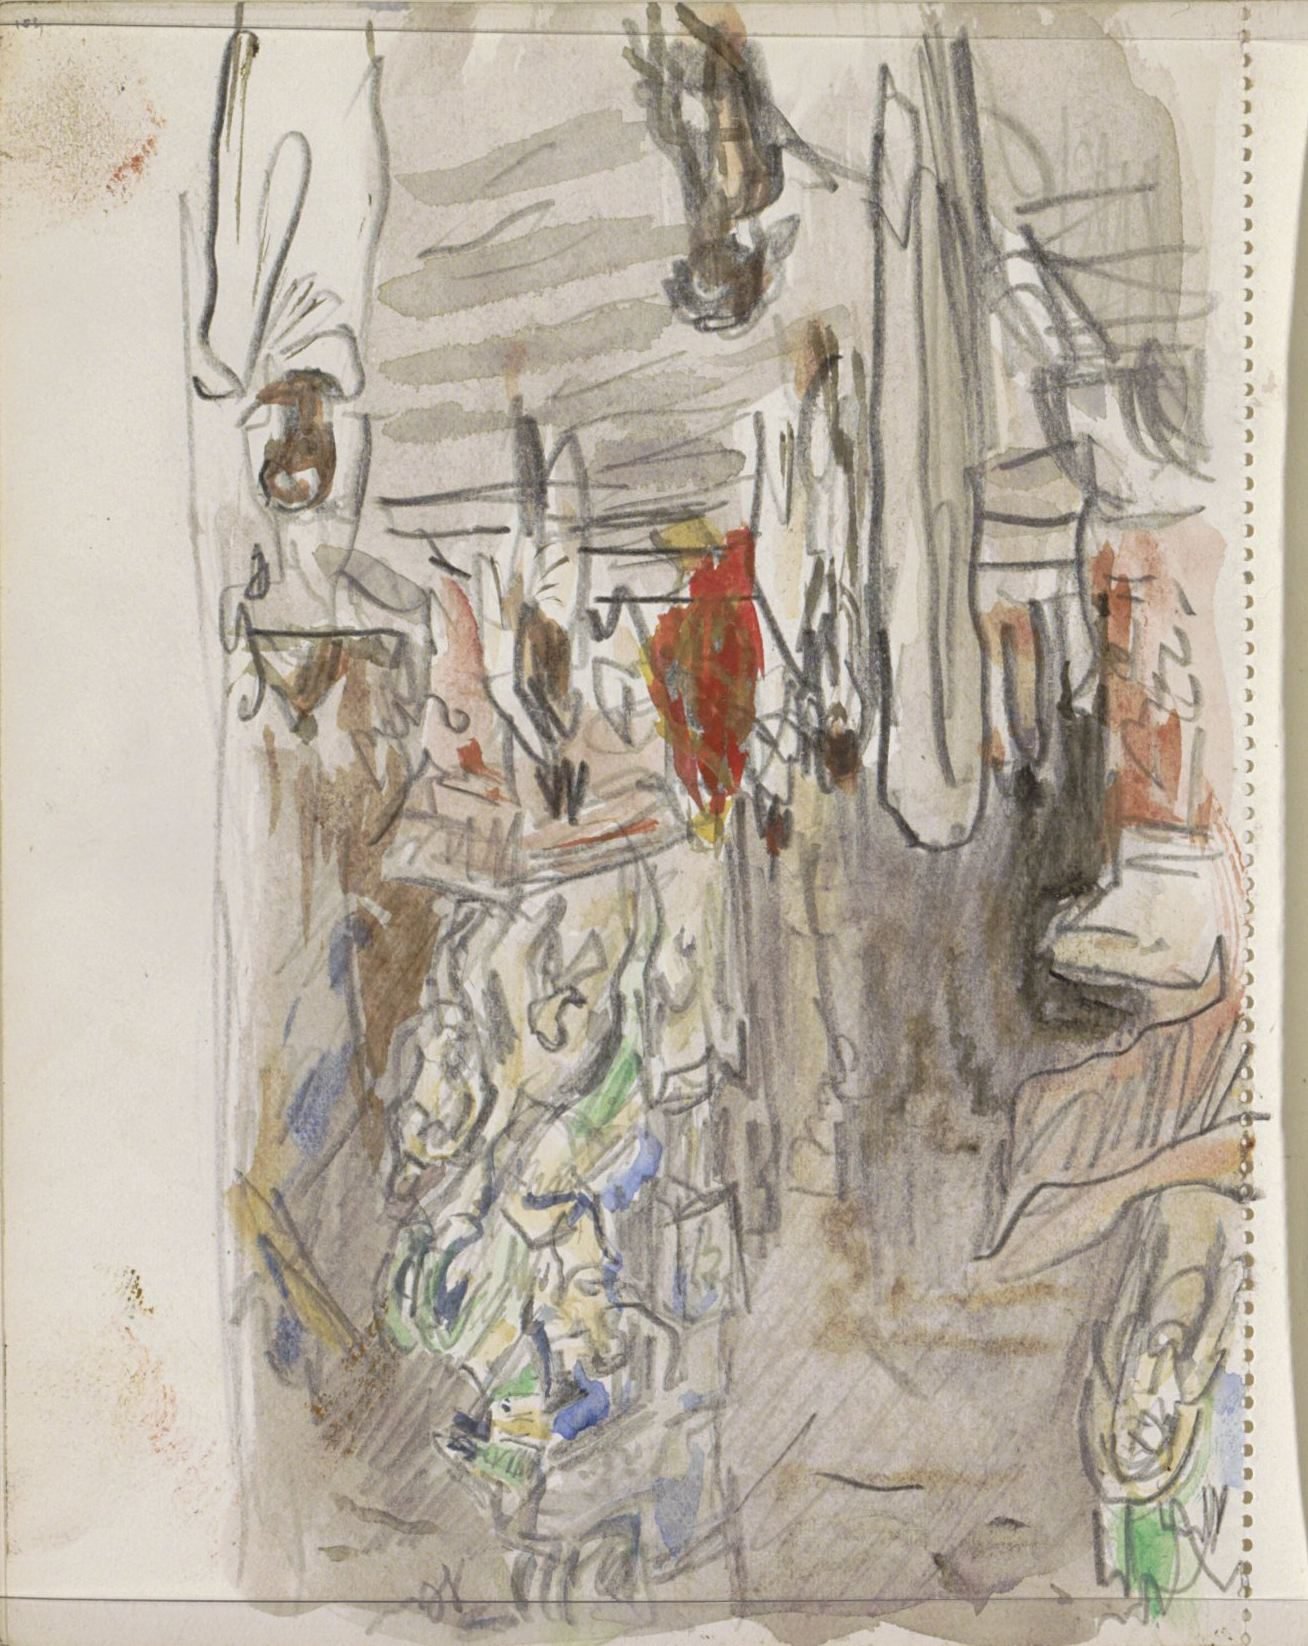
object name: sketchbook leaf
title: Indiërs op een tempeltrap, mogelijk de Meenakshi Amman Tempel in Madurai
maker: marius bauer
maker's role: draughtsman, print maker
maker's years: 1867-1932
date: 1924-1925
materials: paper, pencil, watercolor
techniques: brush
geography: madurai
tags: temple, shrine ~ hinduism, buddhism, jainism, flight of steps, asiatic races and peoples: indians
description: Pagina 104 uit een schetsboek met 75 bladen.